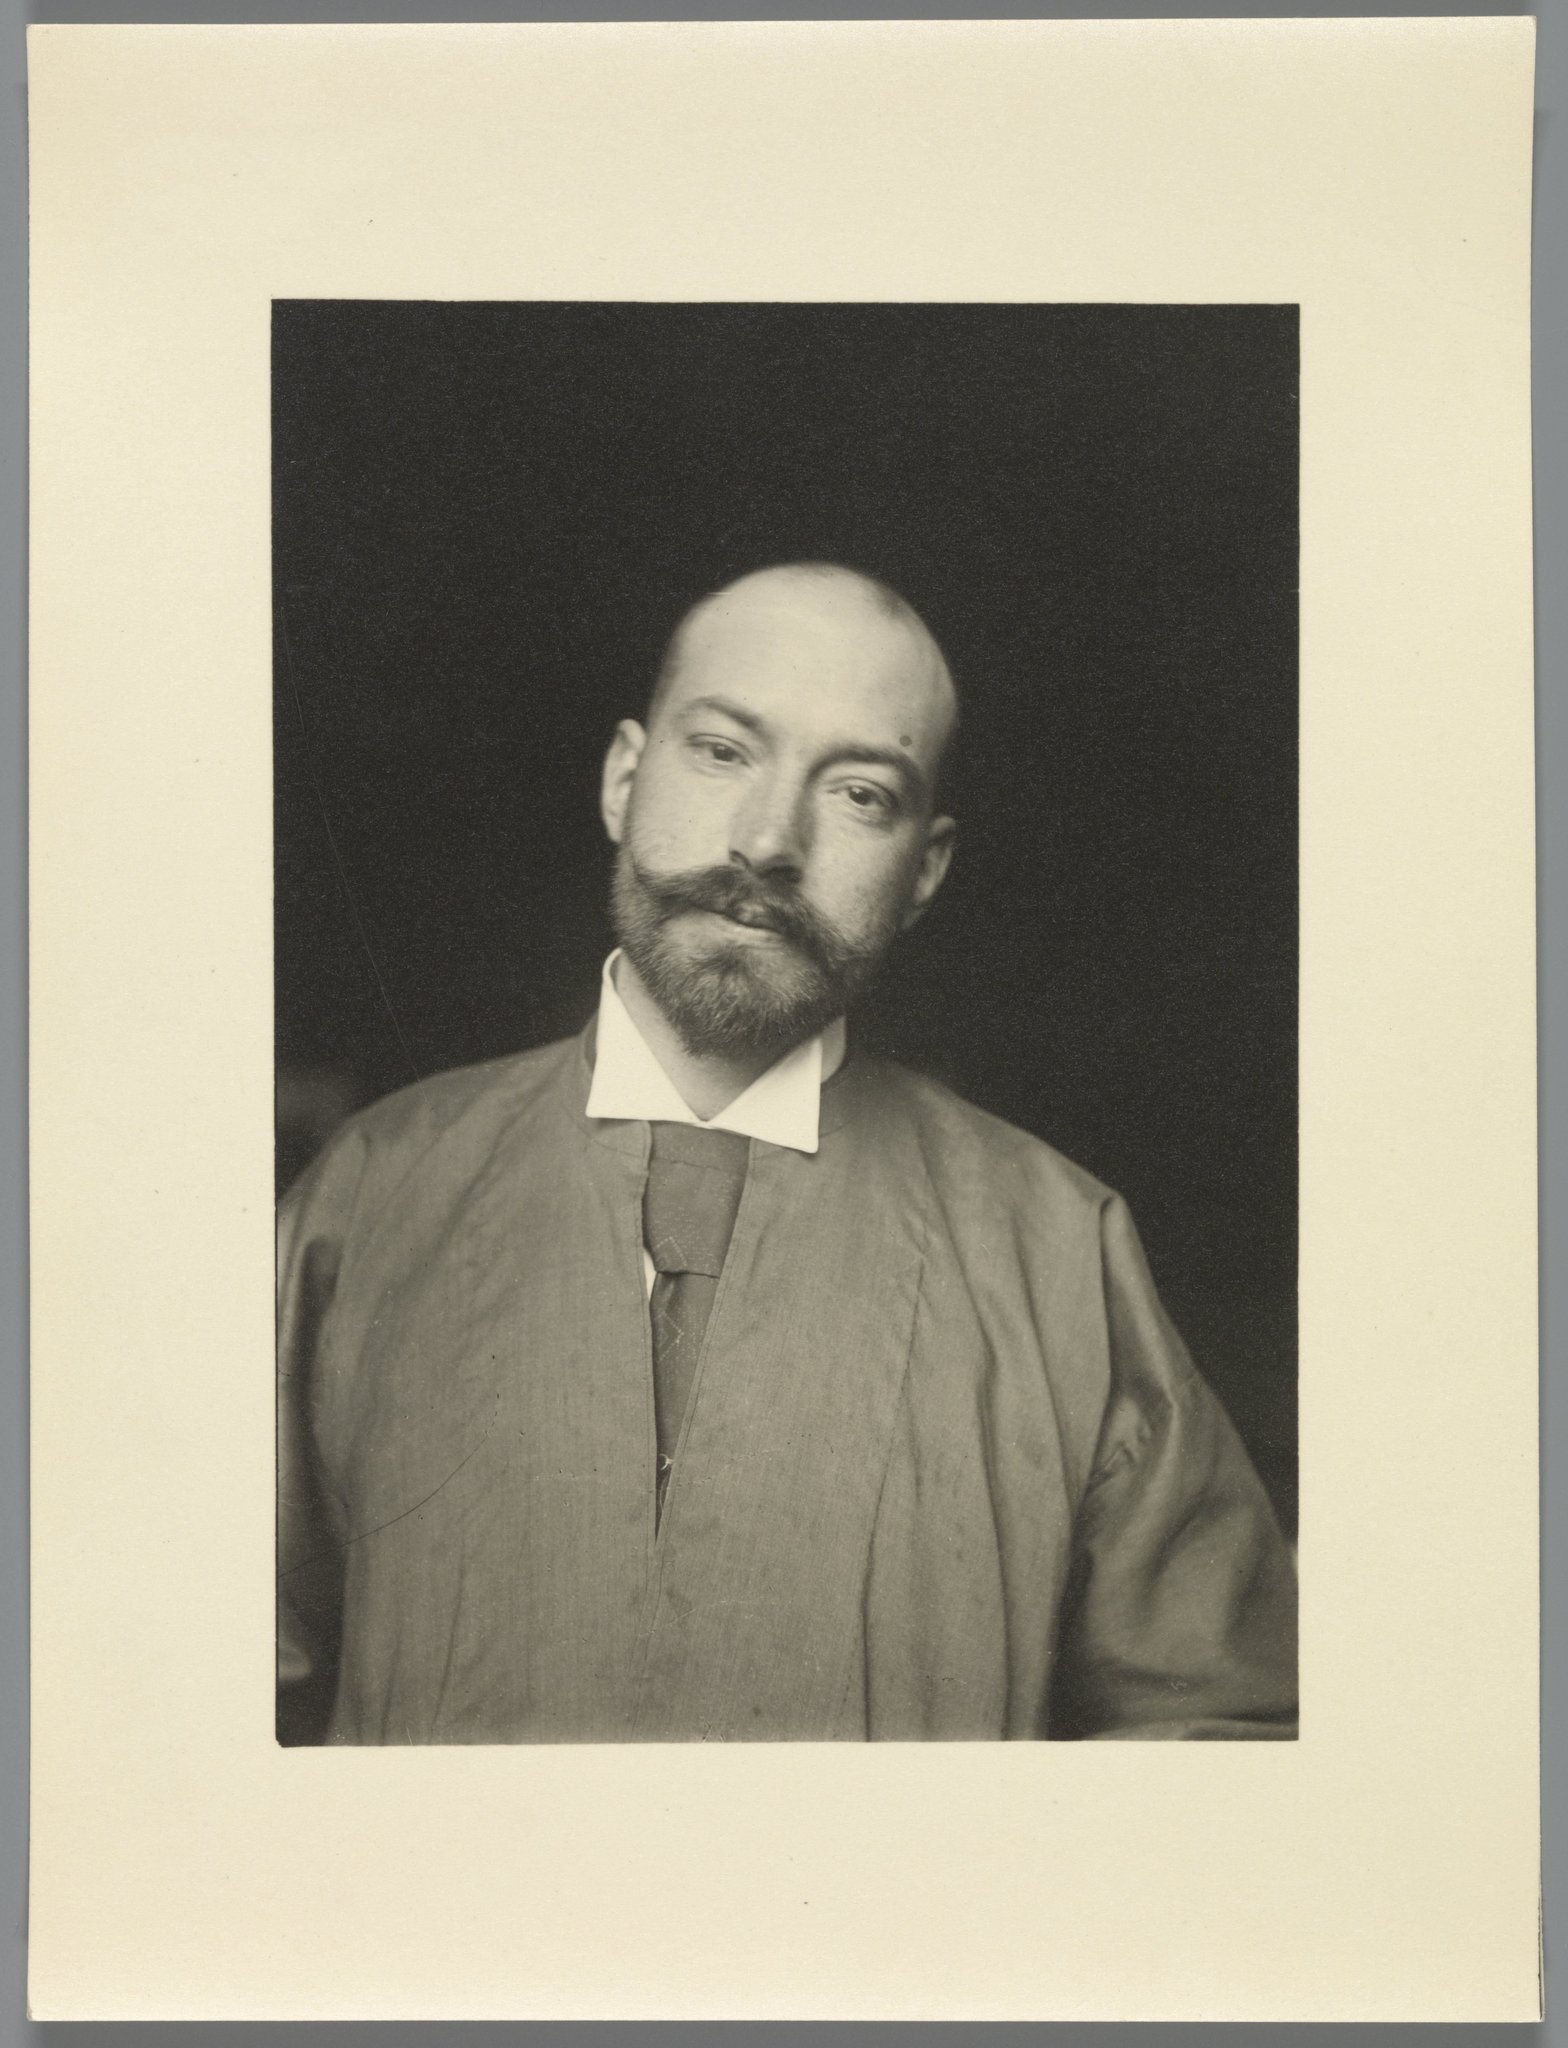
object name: photograph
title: Reproductie naar een foto van Willem Witsen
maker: Anonymous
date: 1860-1915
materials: paper, photographic support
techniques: gelatin silver print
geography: netherlands